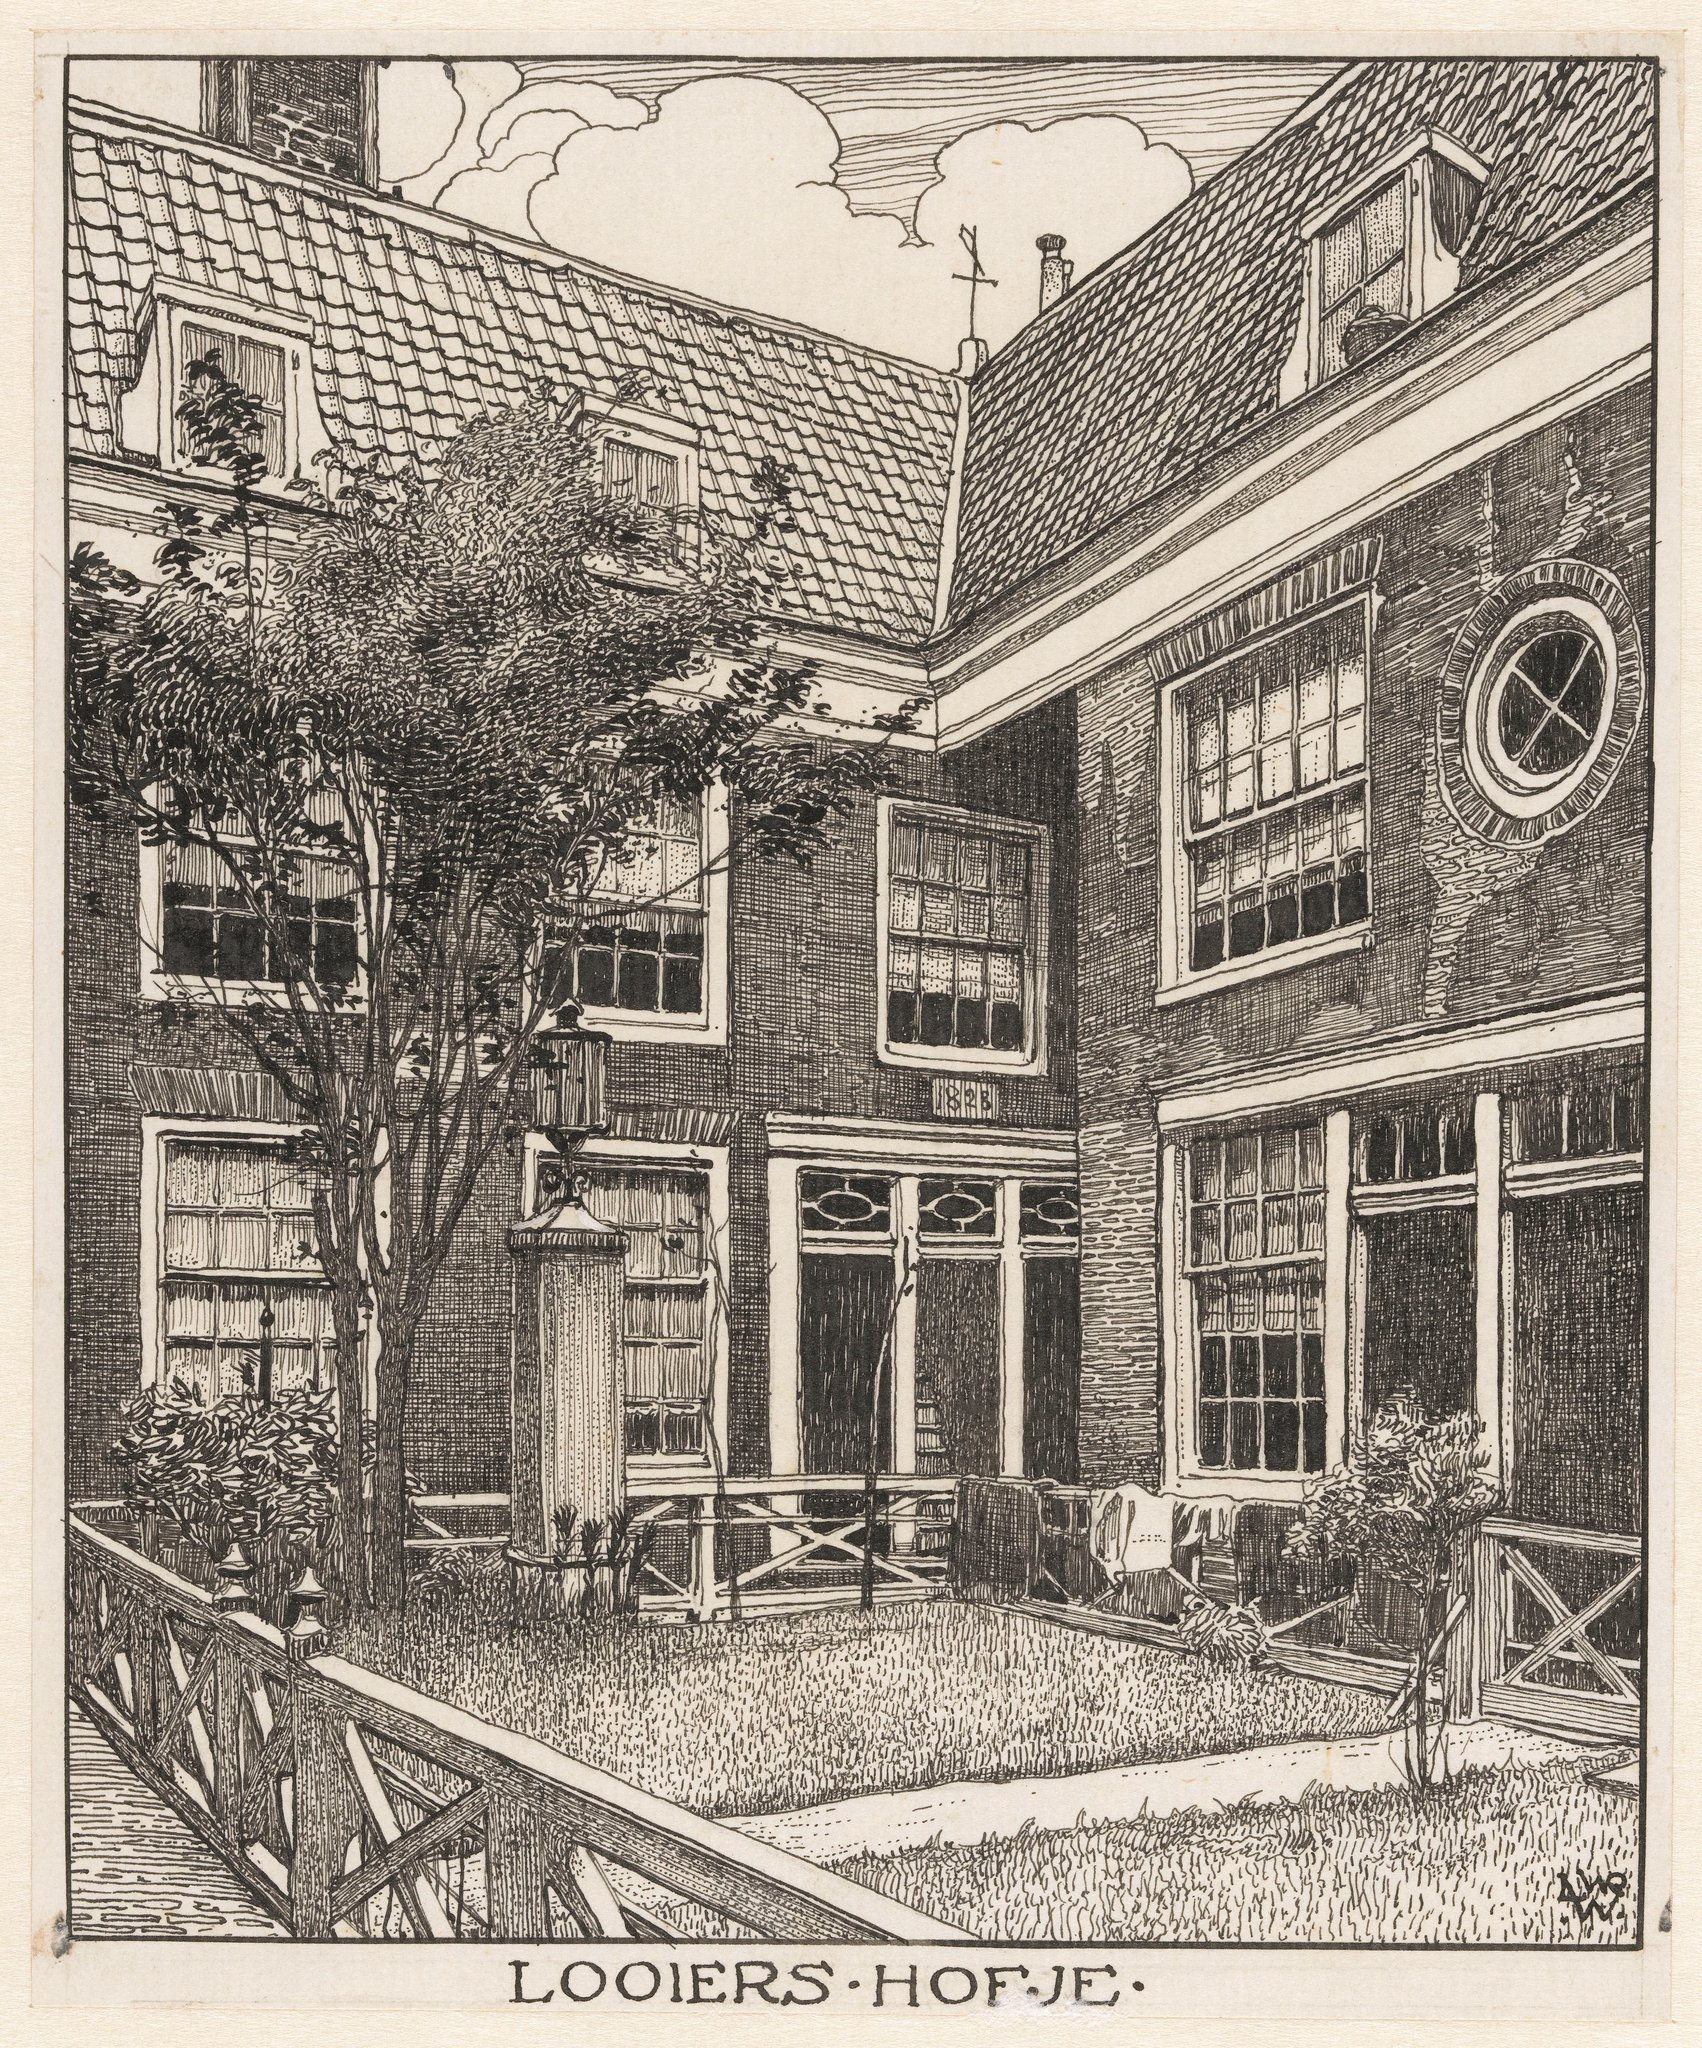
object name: drawing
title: Looiers Hofje te Amsterdam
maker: willem wenckebach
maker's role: designer, draughtsman, painter, print maker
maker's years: 1860-1937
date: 1870-1926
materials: ink, paper, pencil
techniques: pen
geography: amsterdam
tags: alms-house (dutch: 'hofje')